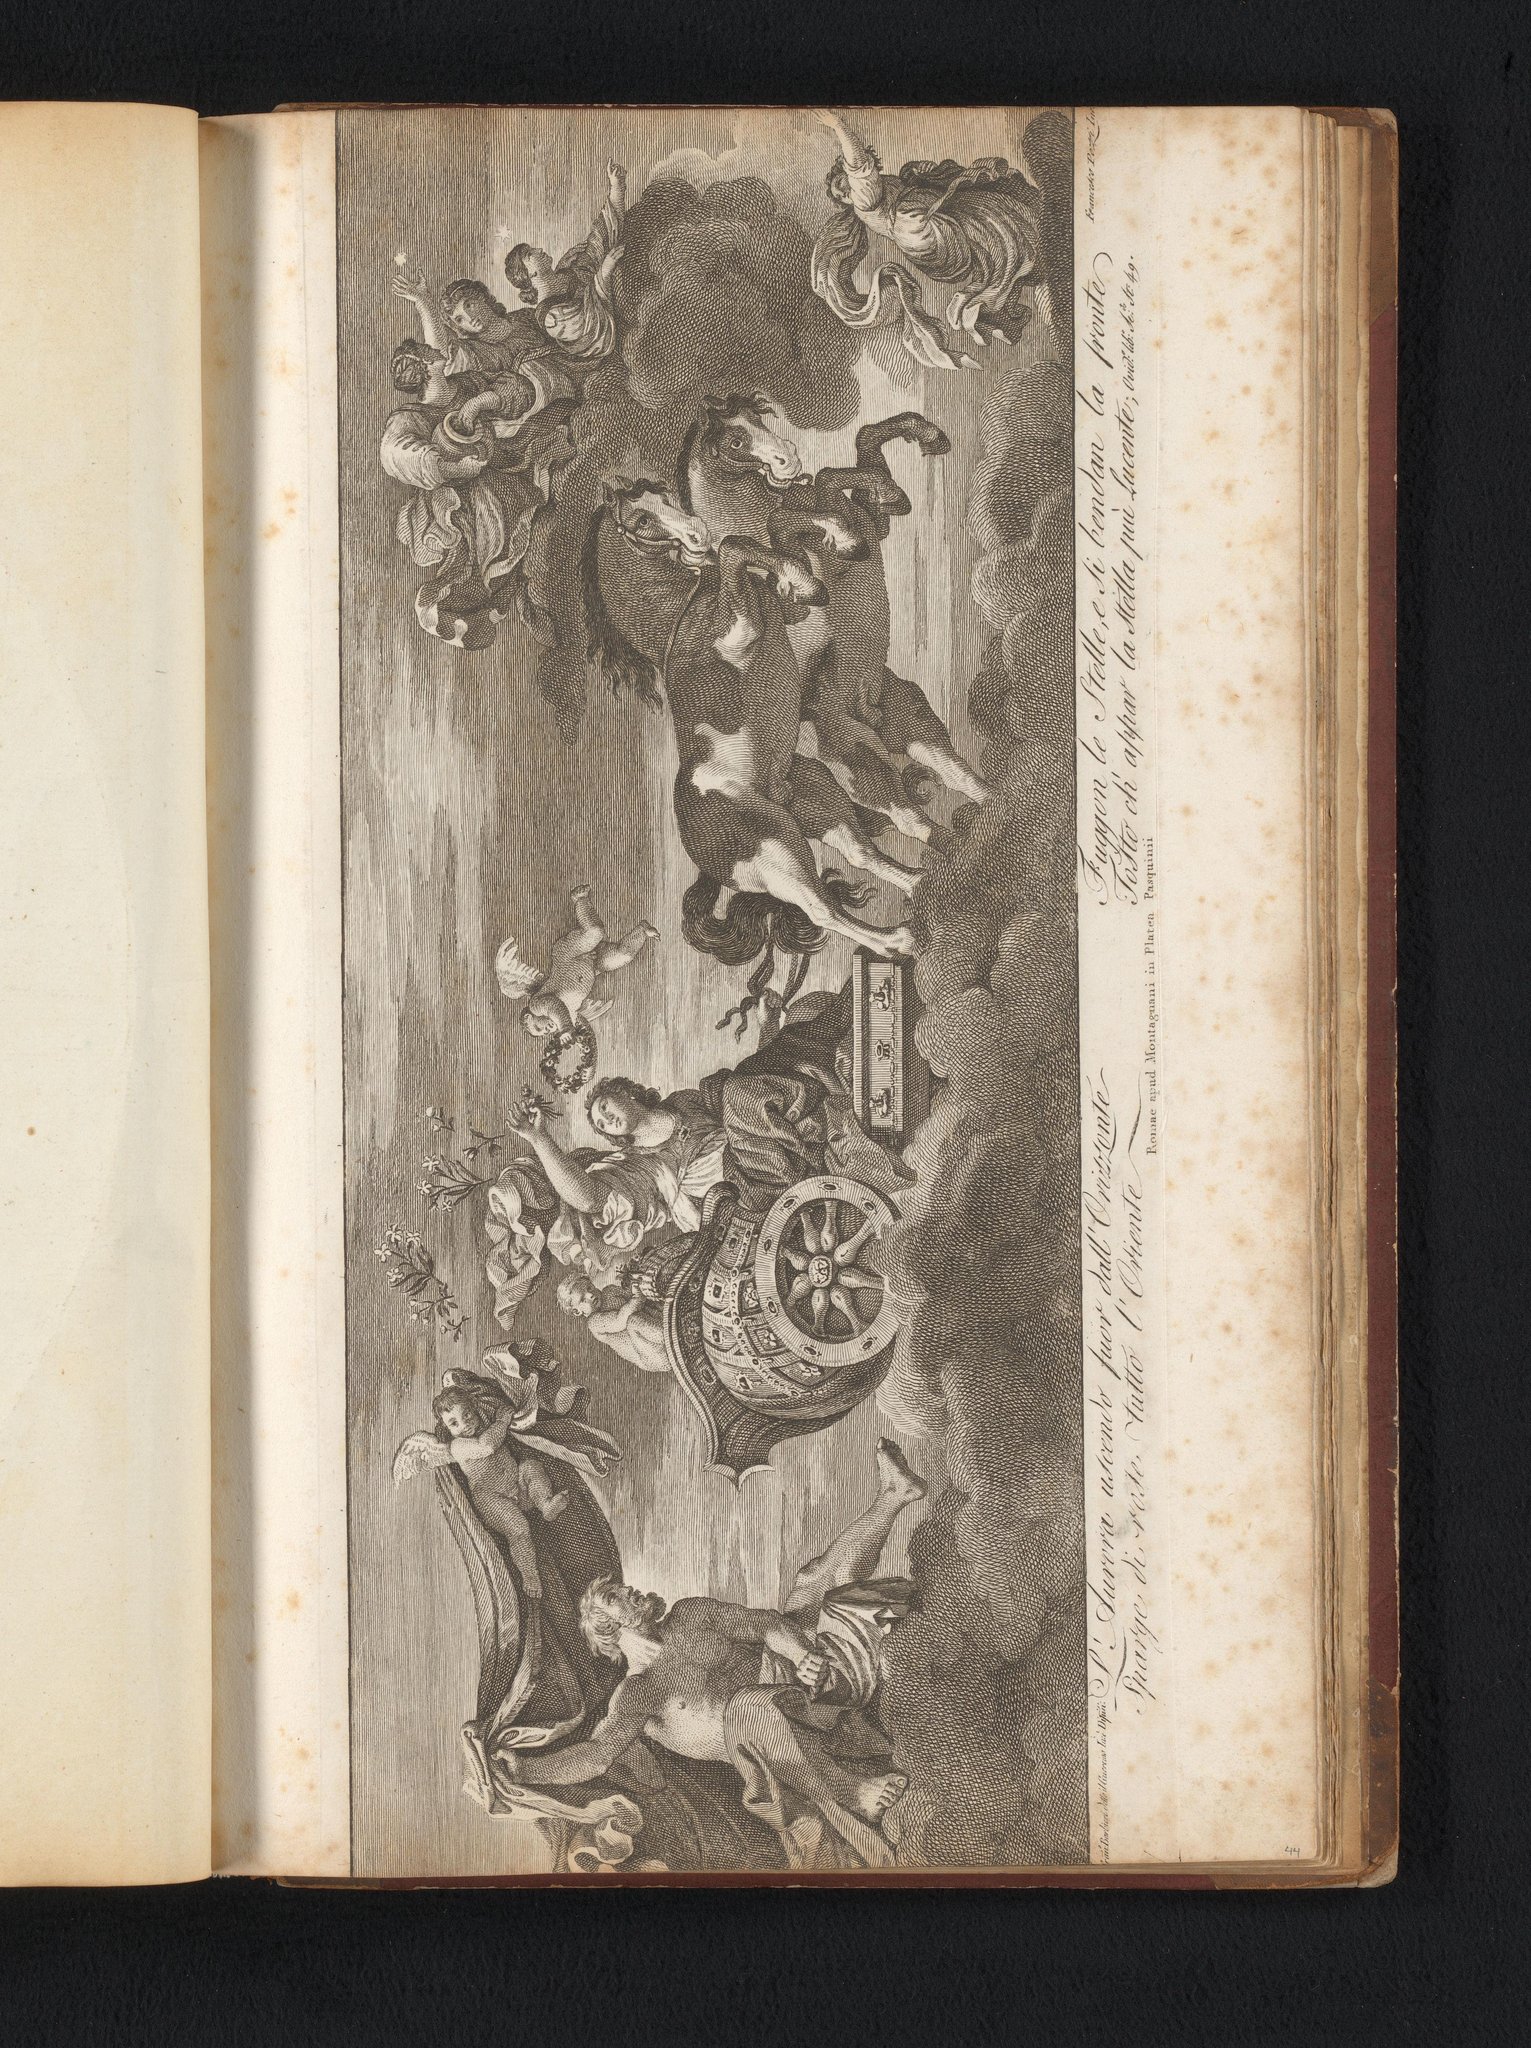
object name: album leaf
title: Aurora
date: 1750-1816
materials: paper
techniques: engraving, etching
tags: triumph of aurora: in her chariot drawn by two (sometimes four) horses, and possibly scattering flowers; aurora's victory over the night; 'carro dell'aurora' (ripa)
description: Ingeplakte prent naar de fresco van Aurora. Onderdeel van het tweede van twee albums met ingeplakte prenten en tekeningen te dienen als tekenvoorbeelden.